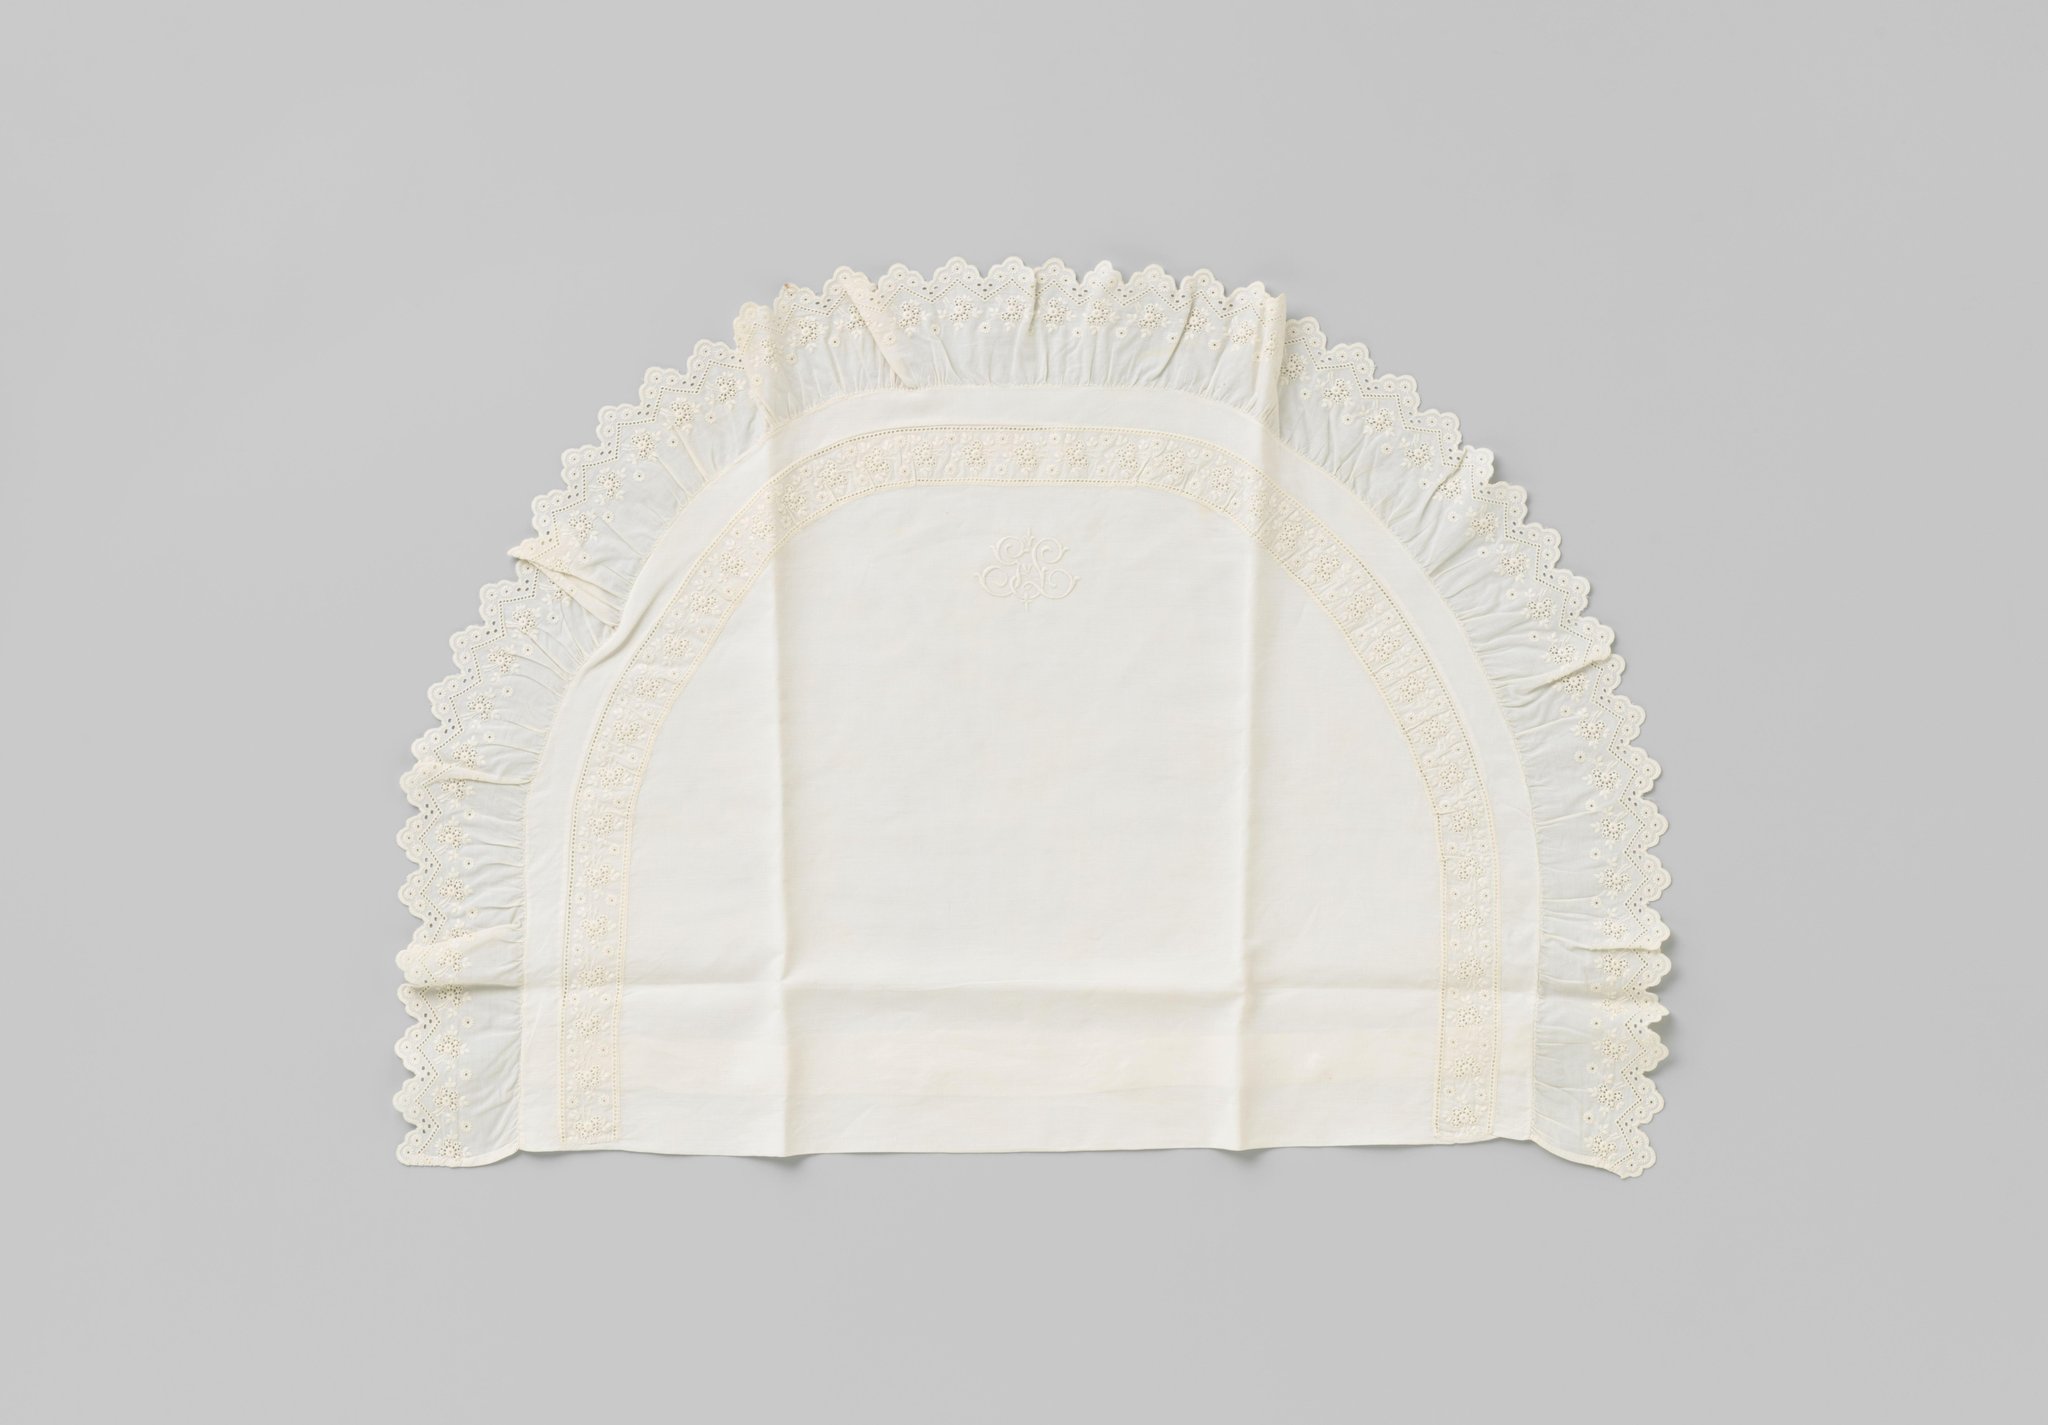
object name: pillowcase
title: Sloop van witte katoen of linnen, halfrond model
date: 1400-1950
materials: cotton, linen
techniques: embroidered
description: Sloop van witte katoen of linnen, halfrond model met geborduurd monogram GvL (Gevers van Lennep) in wit. Tussenzetsel van broderie anglaise en dito licht geplooide rand; sluiting door middel van knopen.